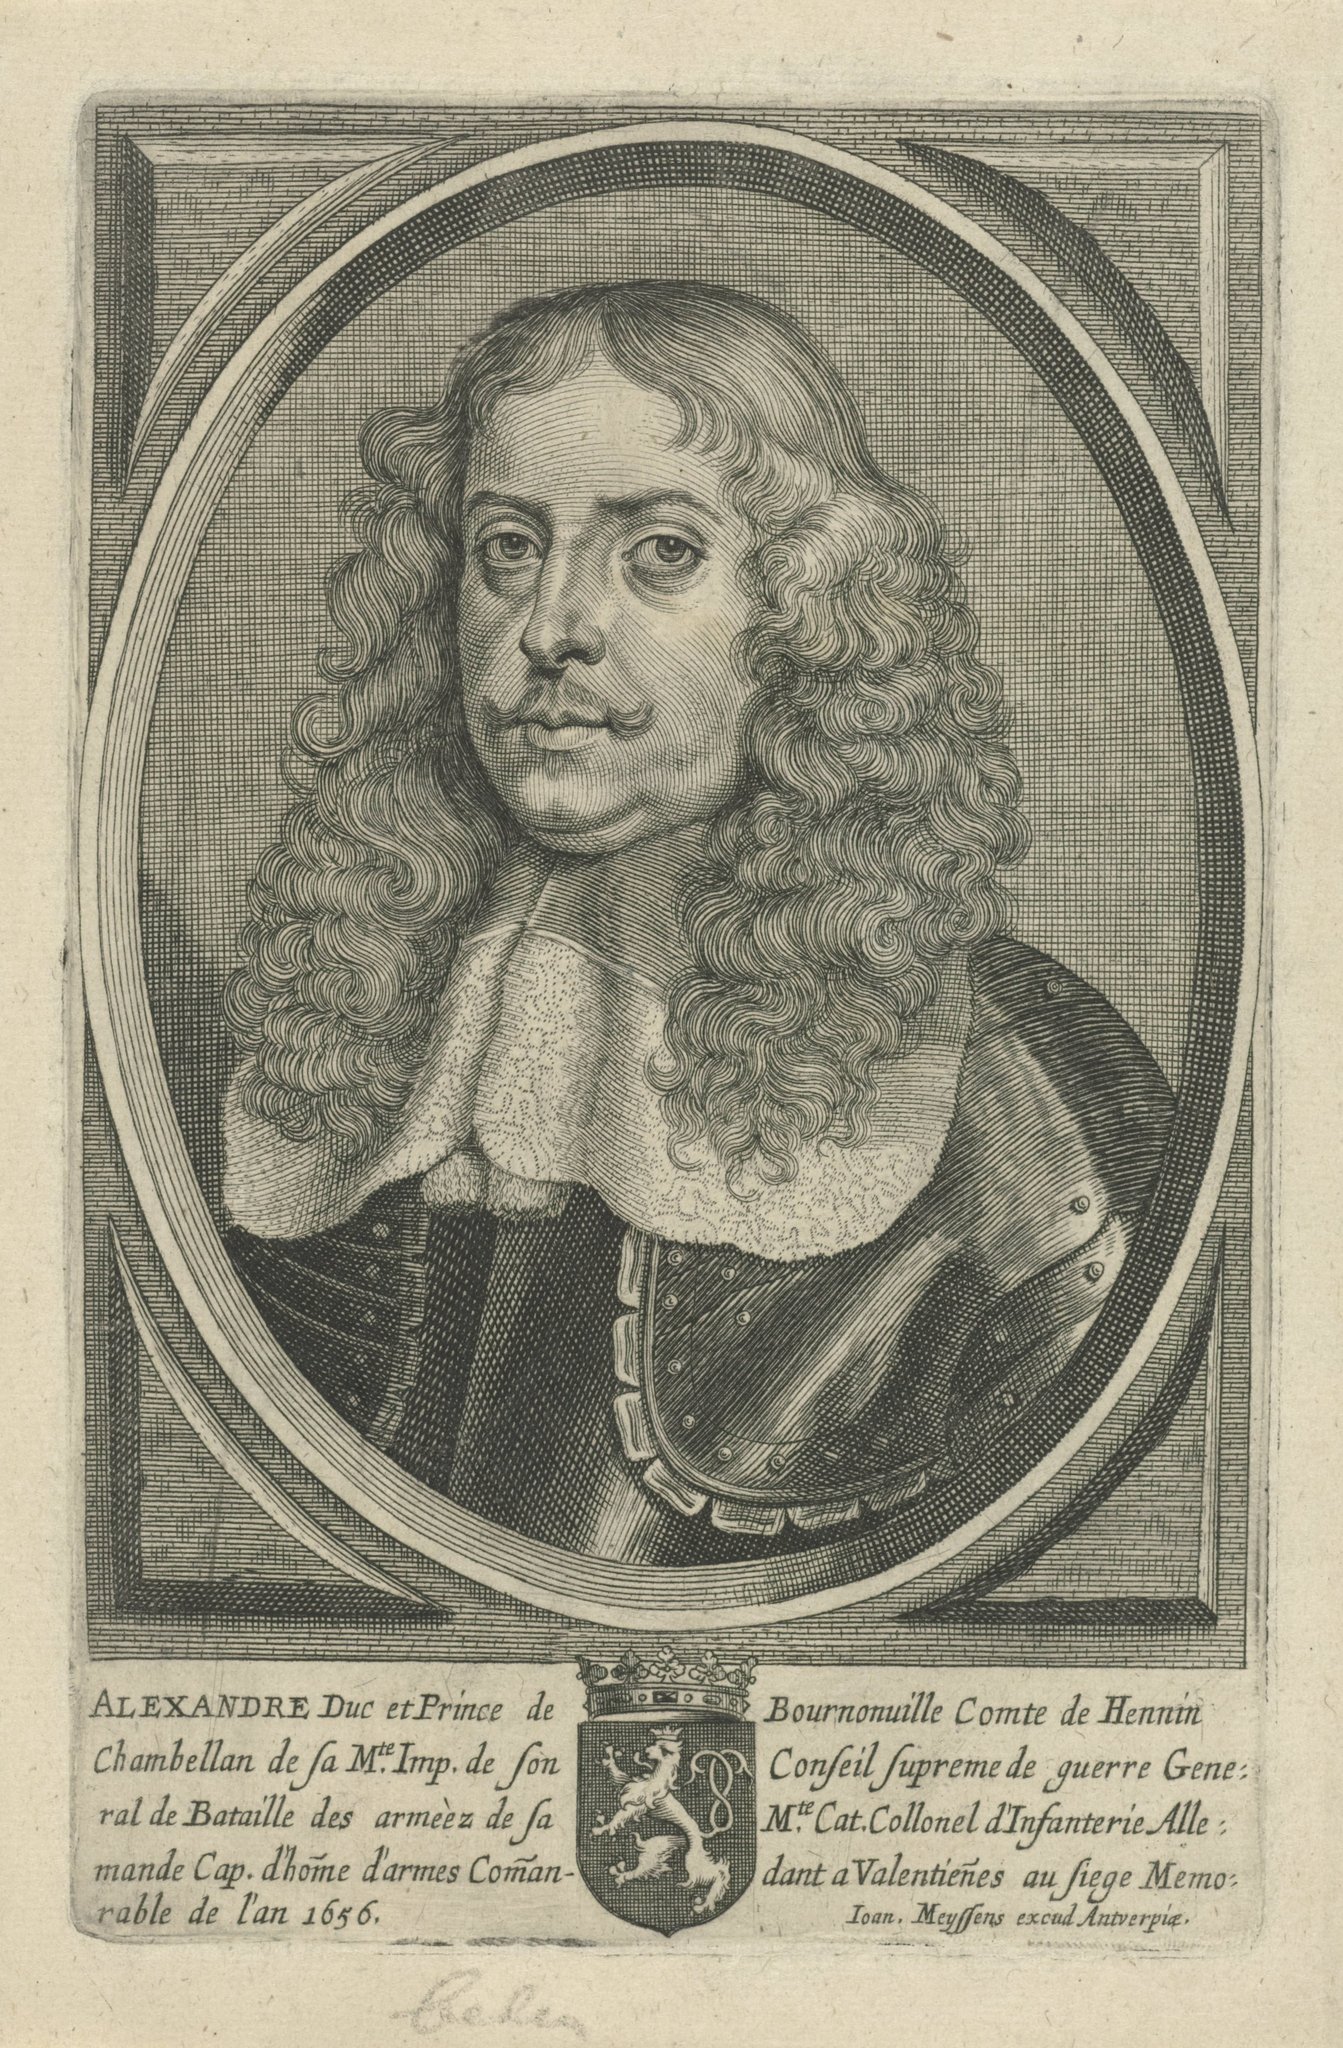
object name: print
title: Portret van Alexander van Bournonville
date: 1650-1670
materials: paper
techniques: engraving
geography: antwerp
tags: brussels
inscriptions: collector's mark: Lugt 2228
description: Portret van Alexander van Bournonville, prins van Bournonville en graaf van Hennin. Midden onder in de marge zijn wapenschild.